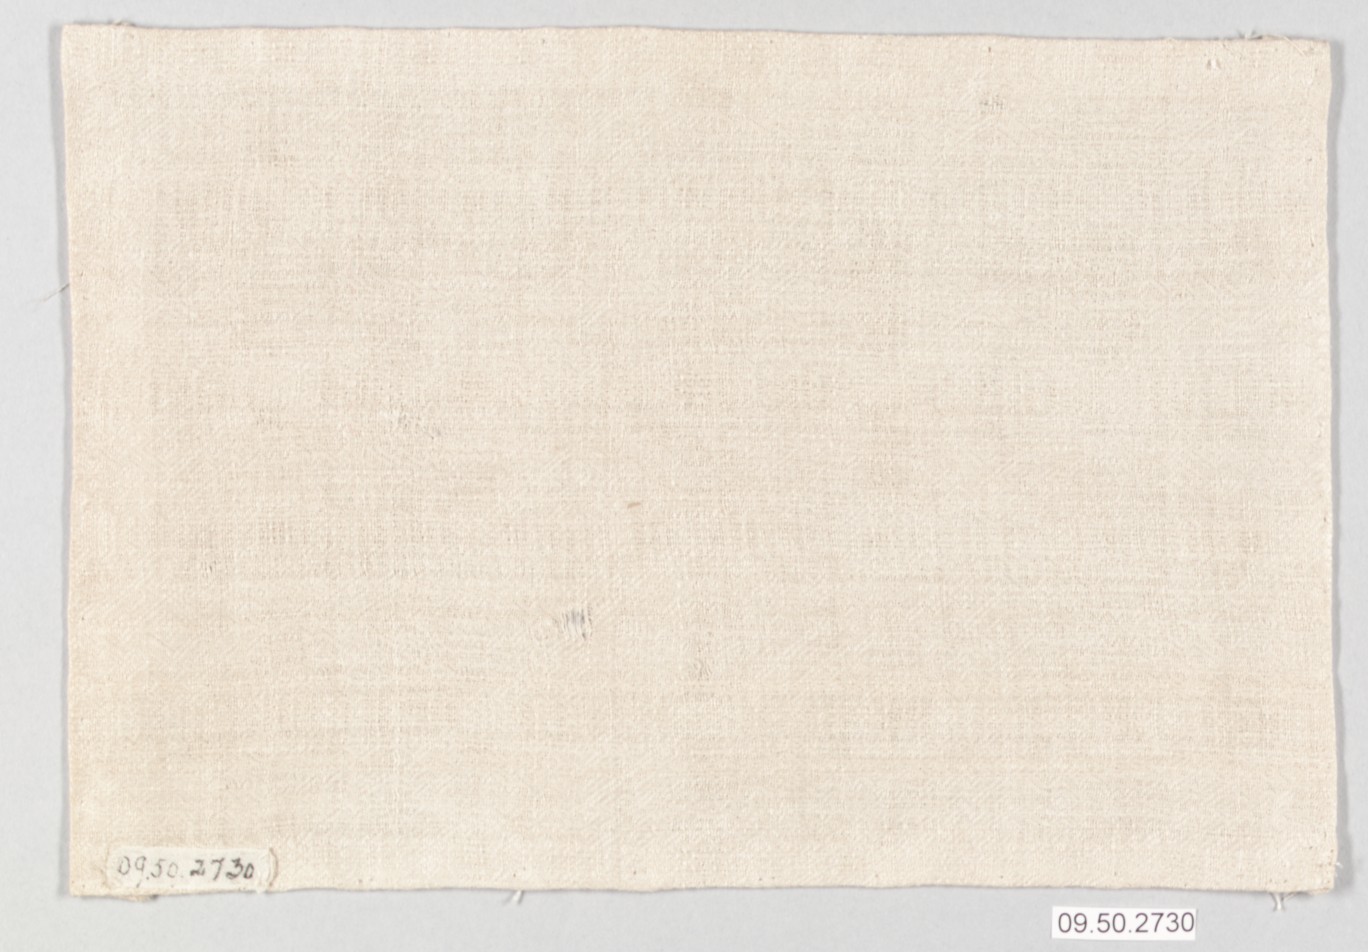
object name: piece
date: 1701-1733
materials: linen